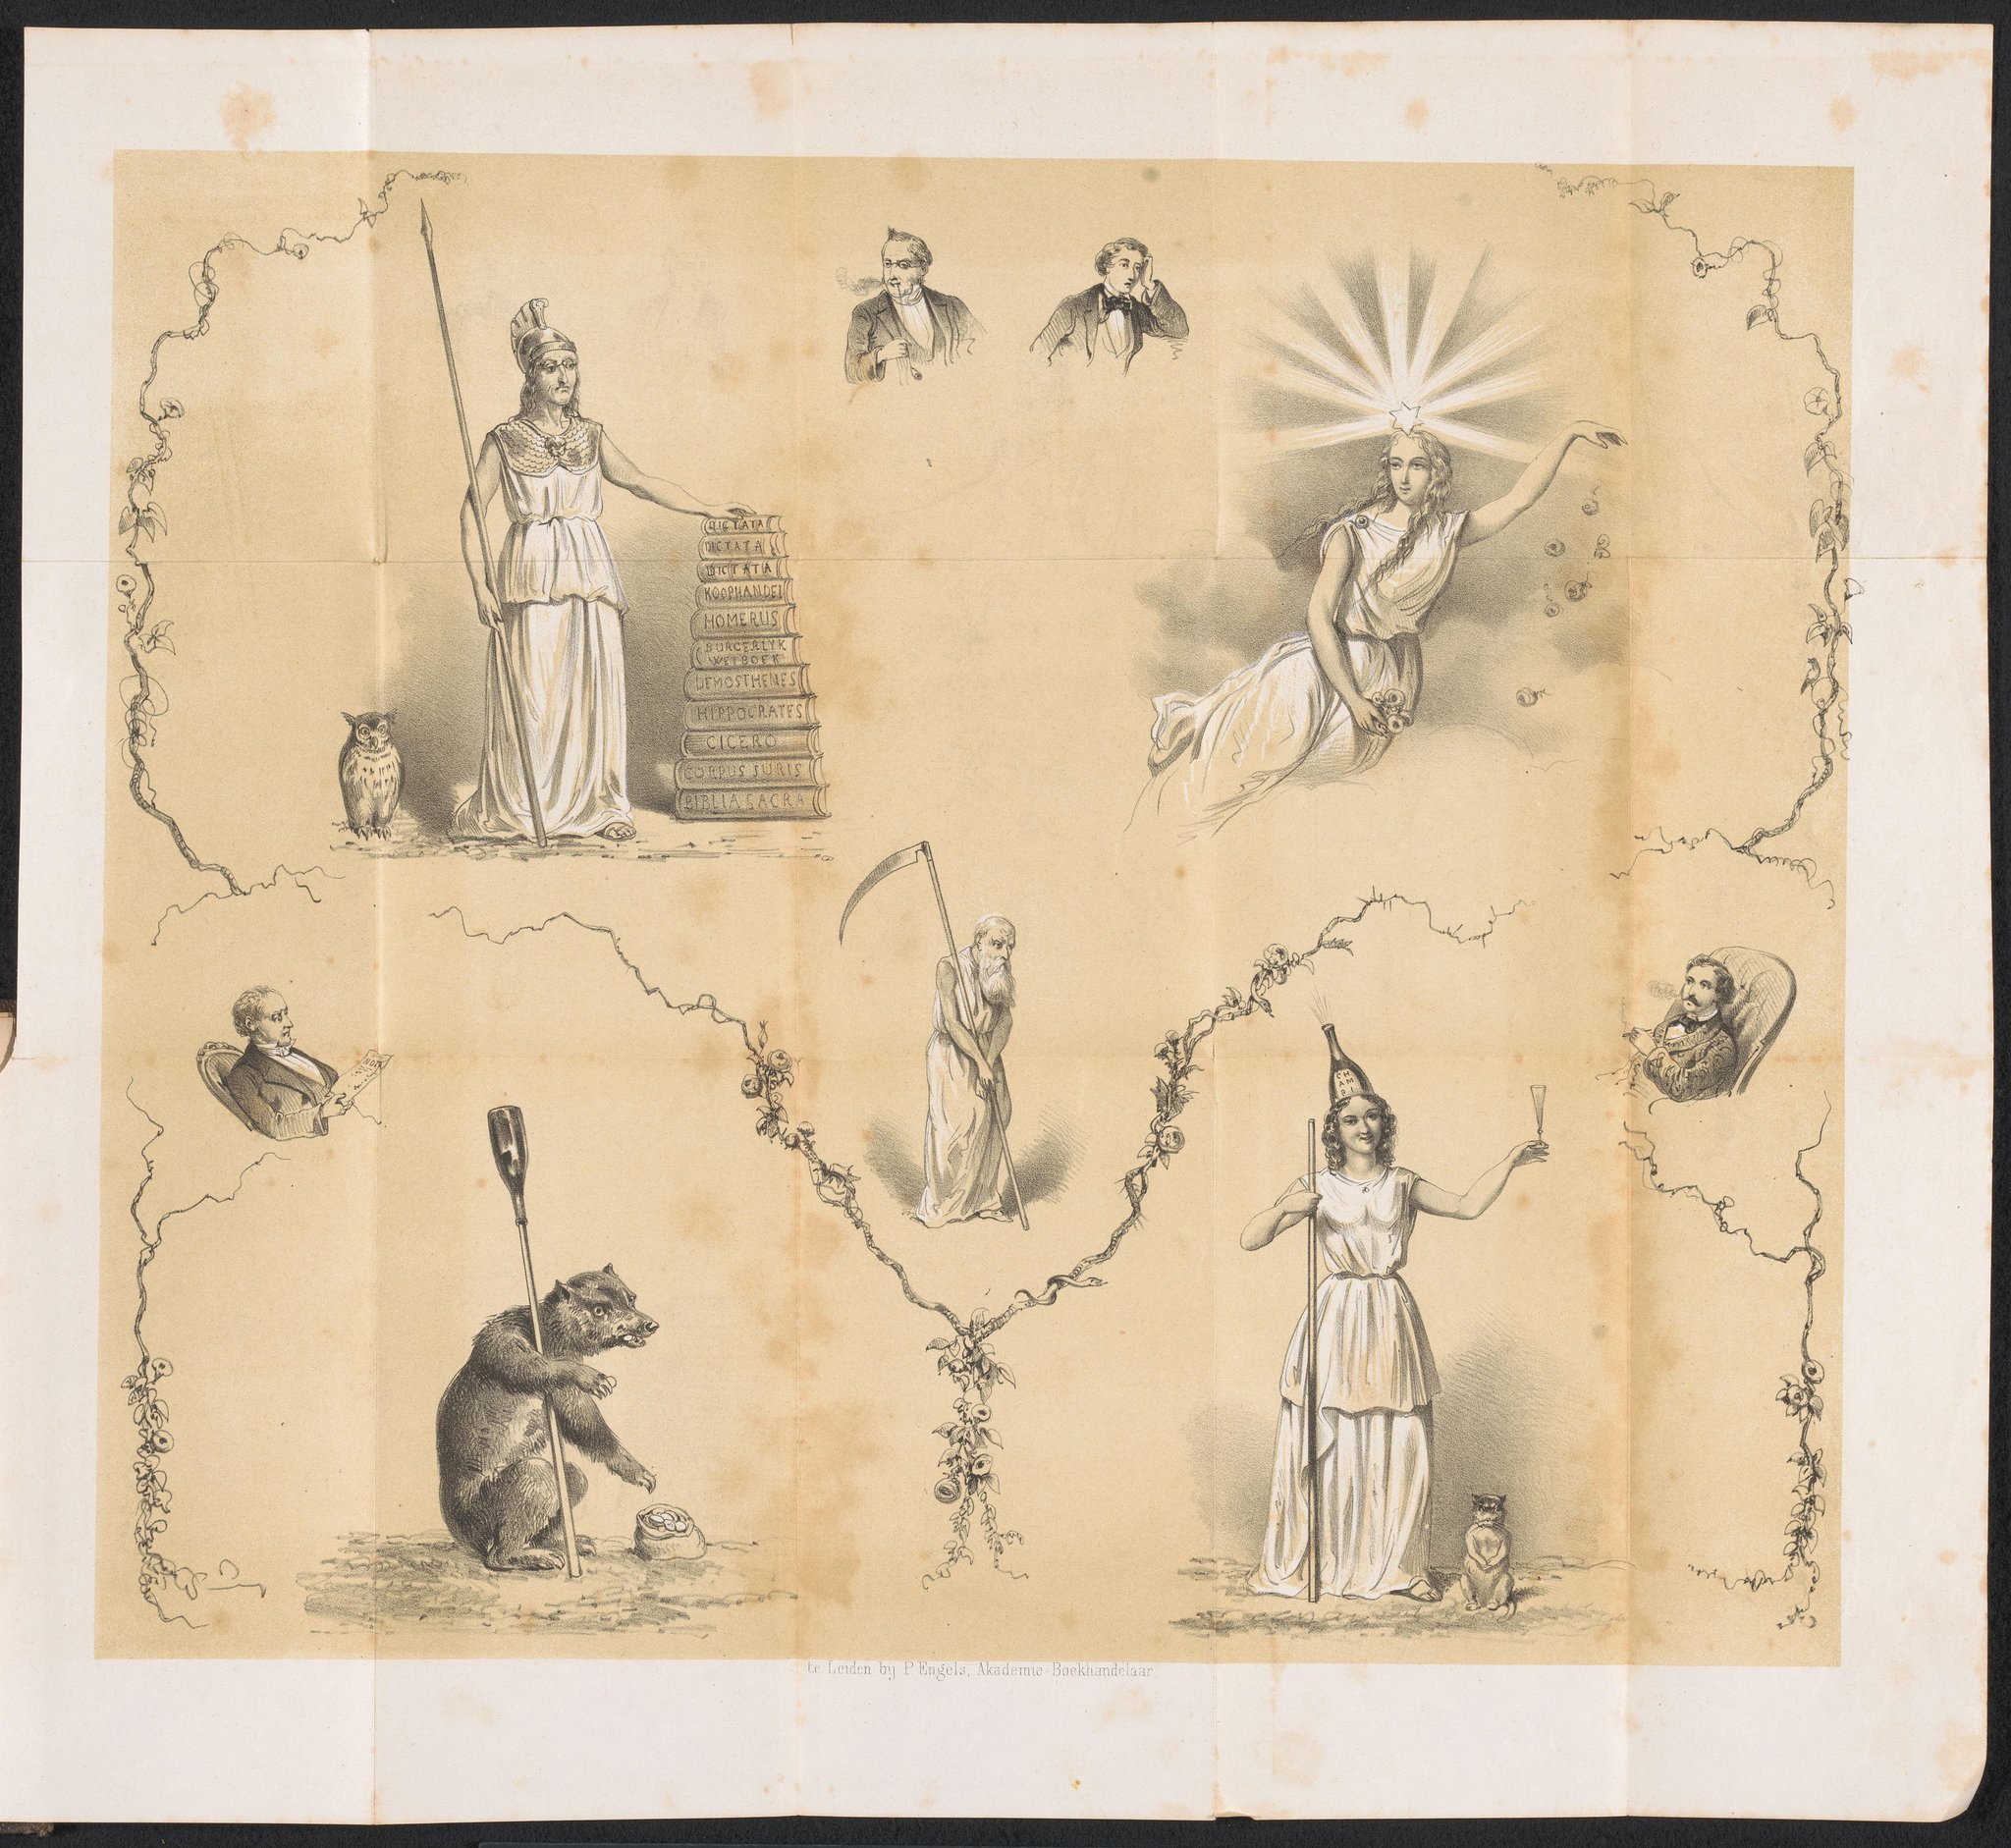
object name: print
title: Spotprent in Leidse studentenalmanak, 1860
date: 1860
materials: paper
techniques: tone lithography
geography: leiden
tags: student life, leiden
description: Spotprent op de loopbaan van een student. Aan het begin een strenge Minerva met boeken en een uil, aan het eind een lachende Minerva met champagne en een opzittende kat. Spotprent in de studentenalmanak van de Universiteit van Leiden van het jaar 1860.